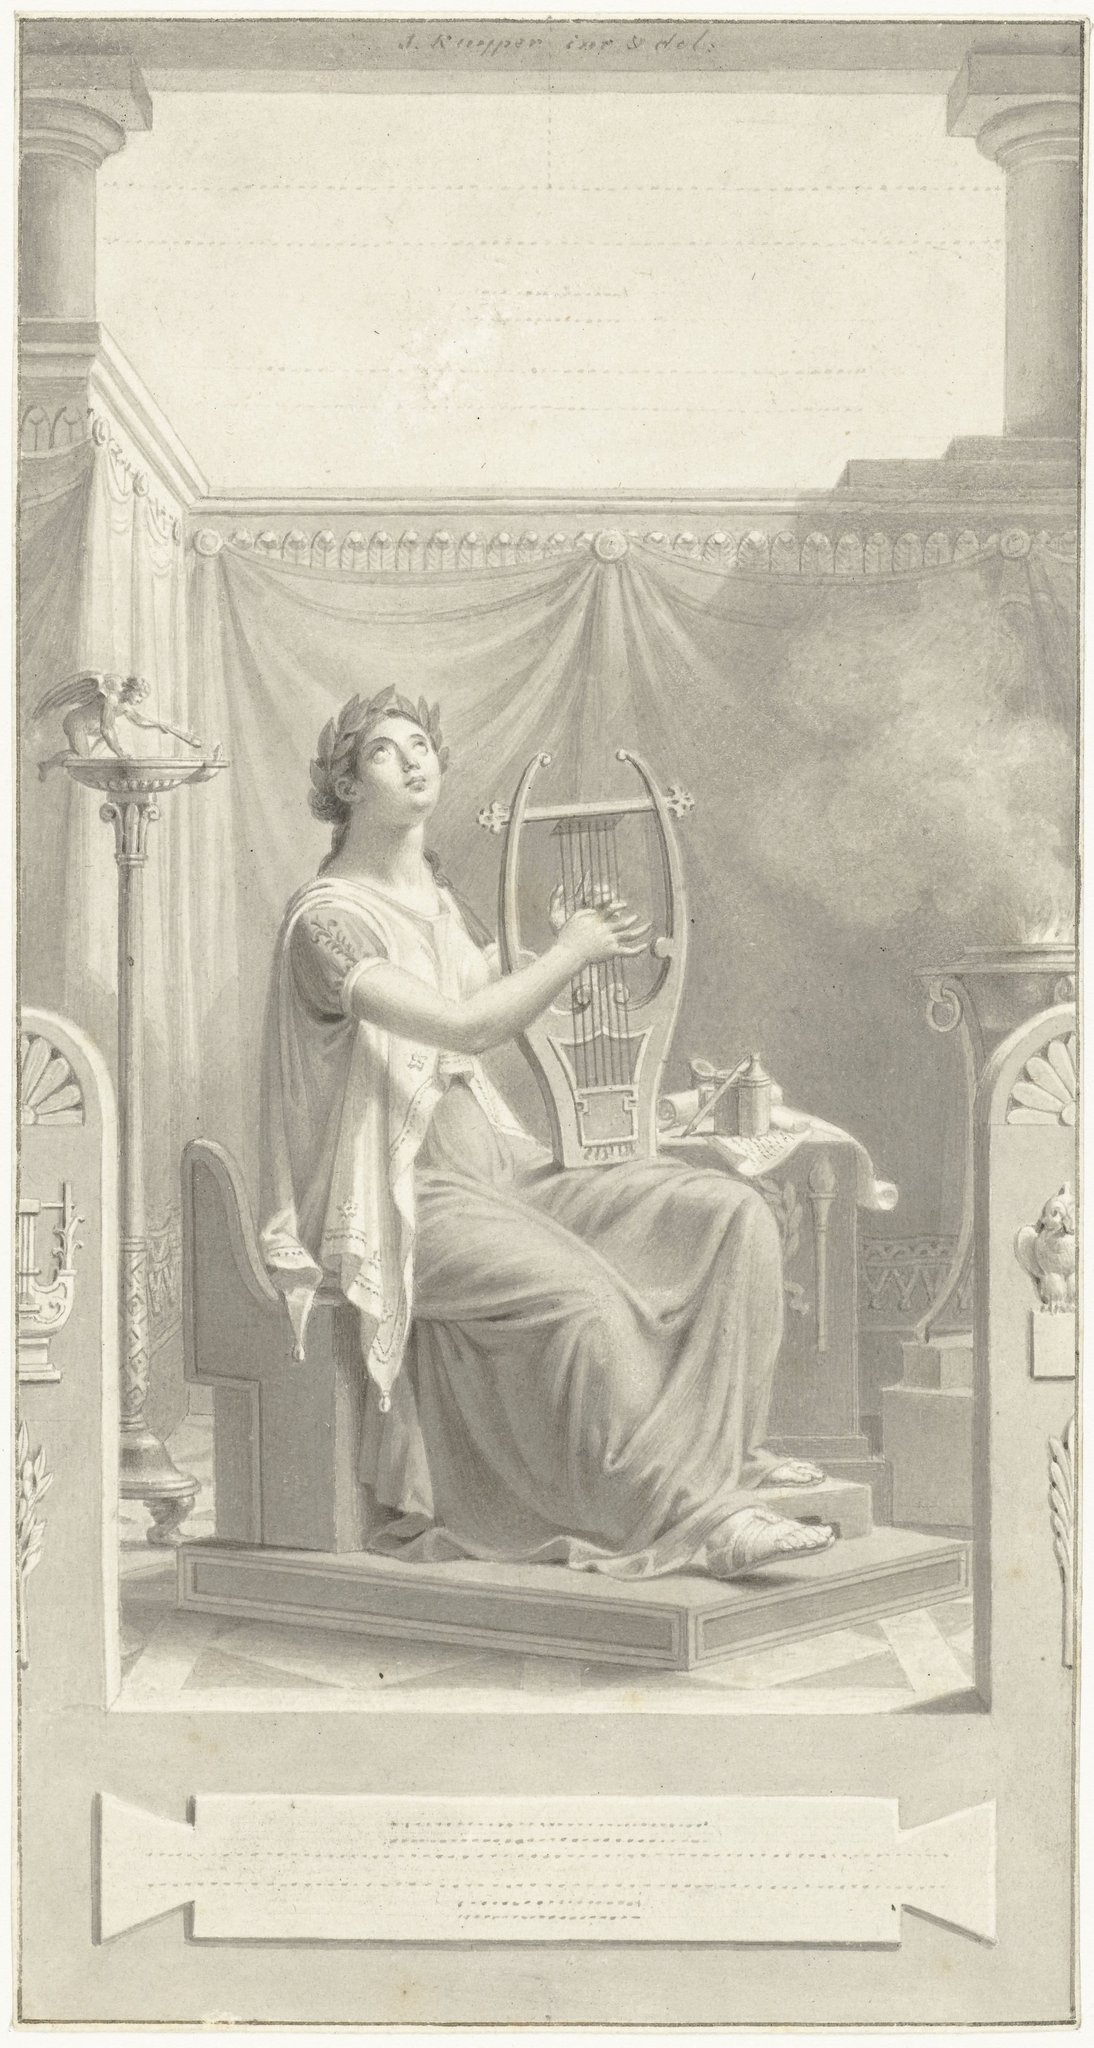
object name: drawing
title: Ontwerp voor het titelblad voor Gedichten van H. Tollens Czn.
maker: jacques kuyper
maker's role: draughtsman, print maker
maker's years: 1761-1808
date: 1771-1808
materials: ink, paper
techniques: brush, pen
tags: euterpe (one of the muses); 'euterpe' (ripa)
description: Ontwerp voor het titelblad voor "Gedichten" van H. Tollens Czn.